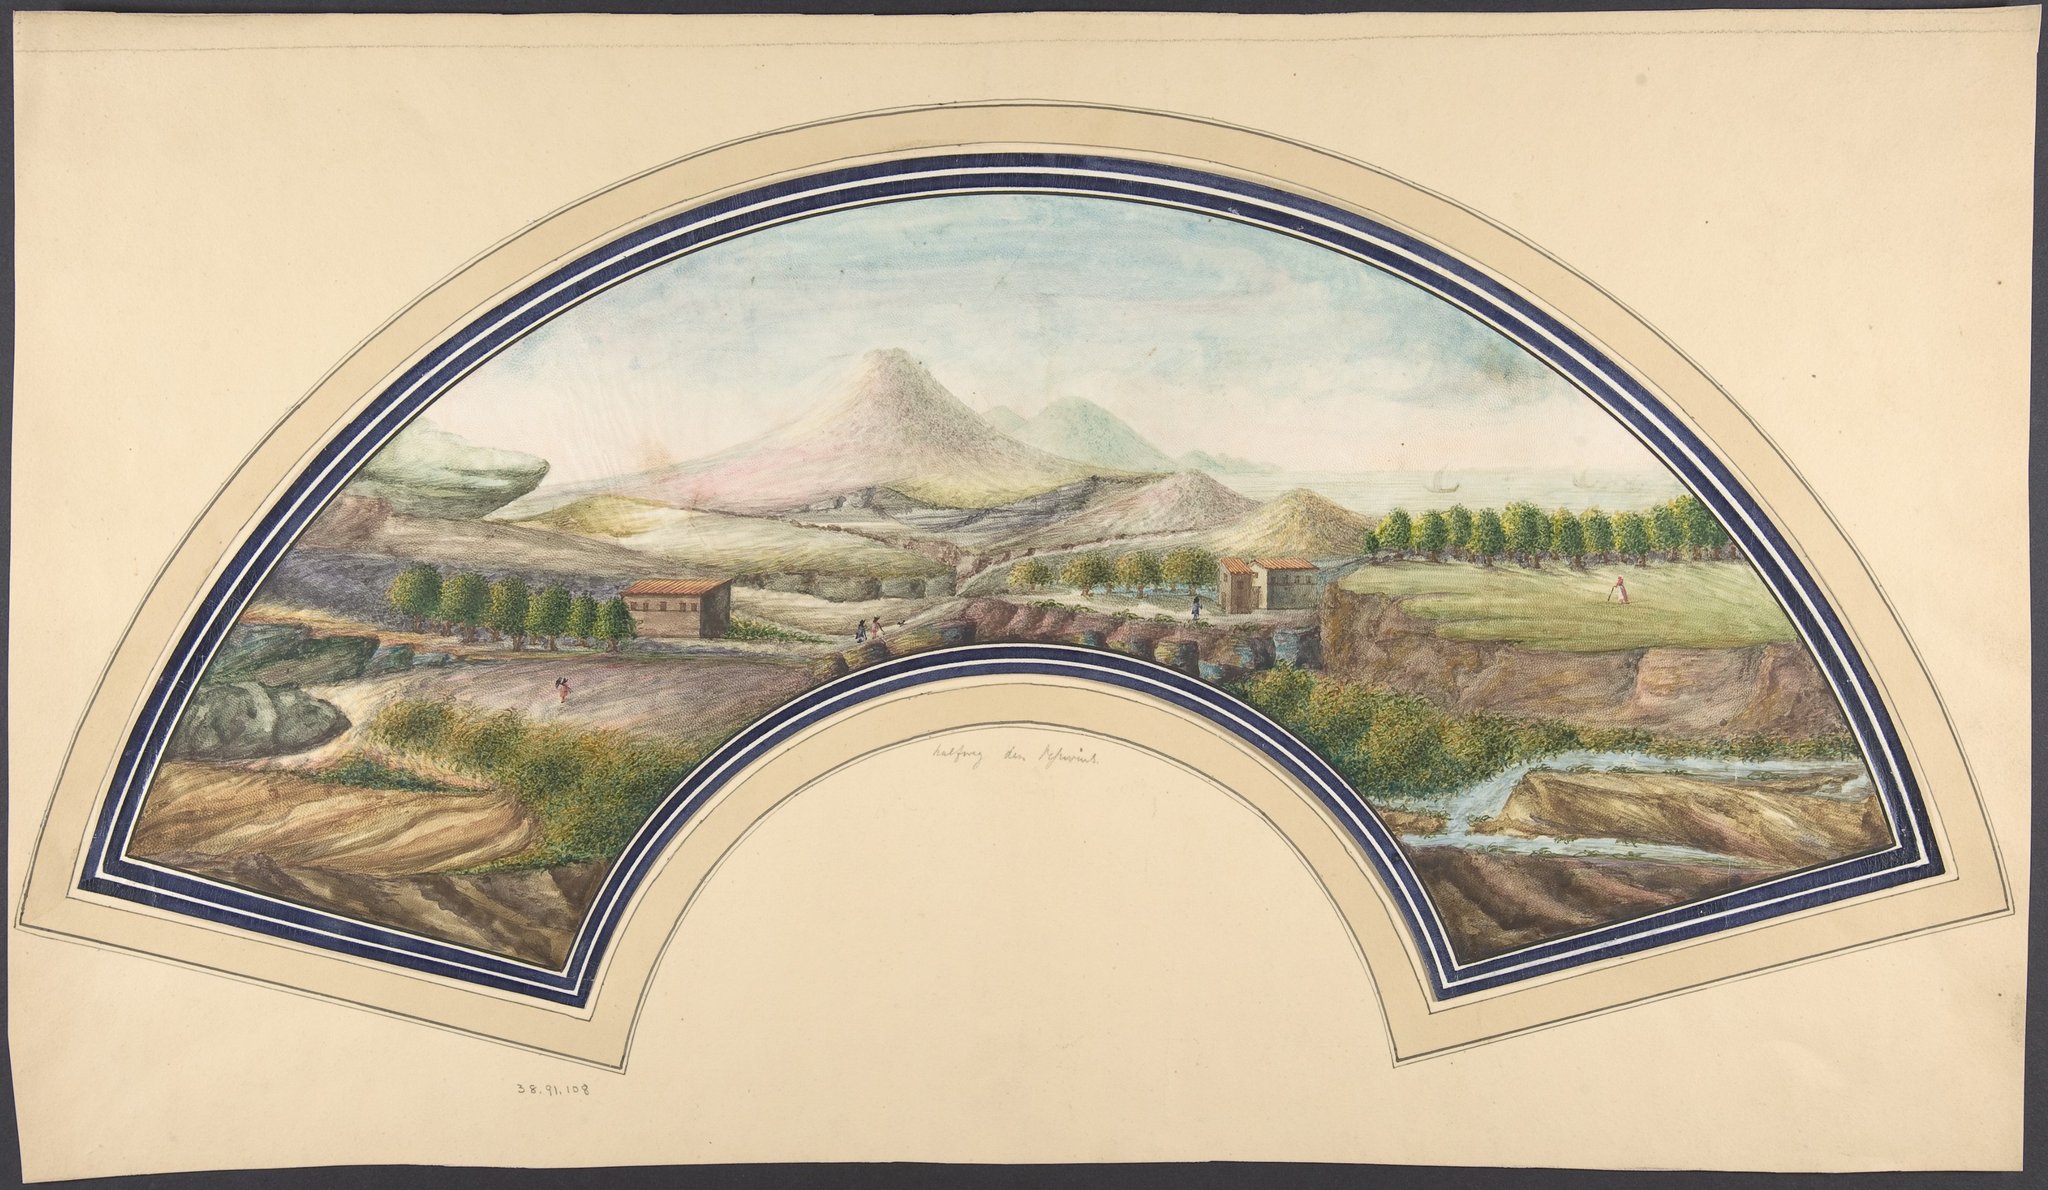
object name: drawing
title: Fan Design with Mount Vesuvius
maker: anonymous, 19th century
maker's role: artist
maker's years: 1800-1900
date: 1801-1900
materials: ink, parchment, watercolor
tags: fans,volcanoes,landscapes